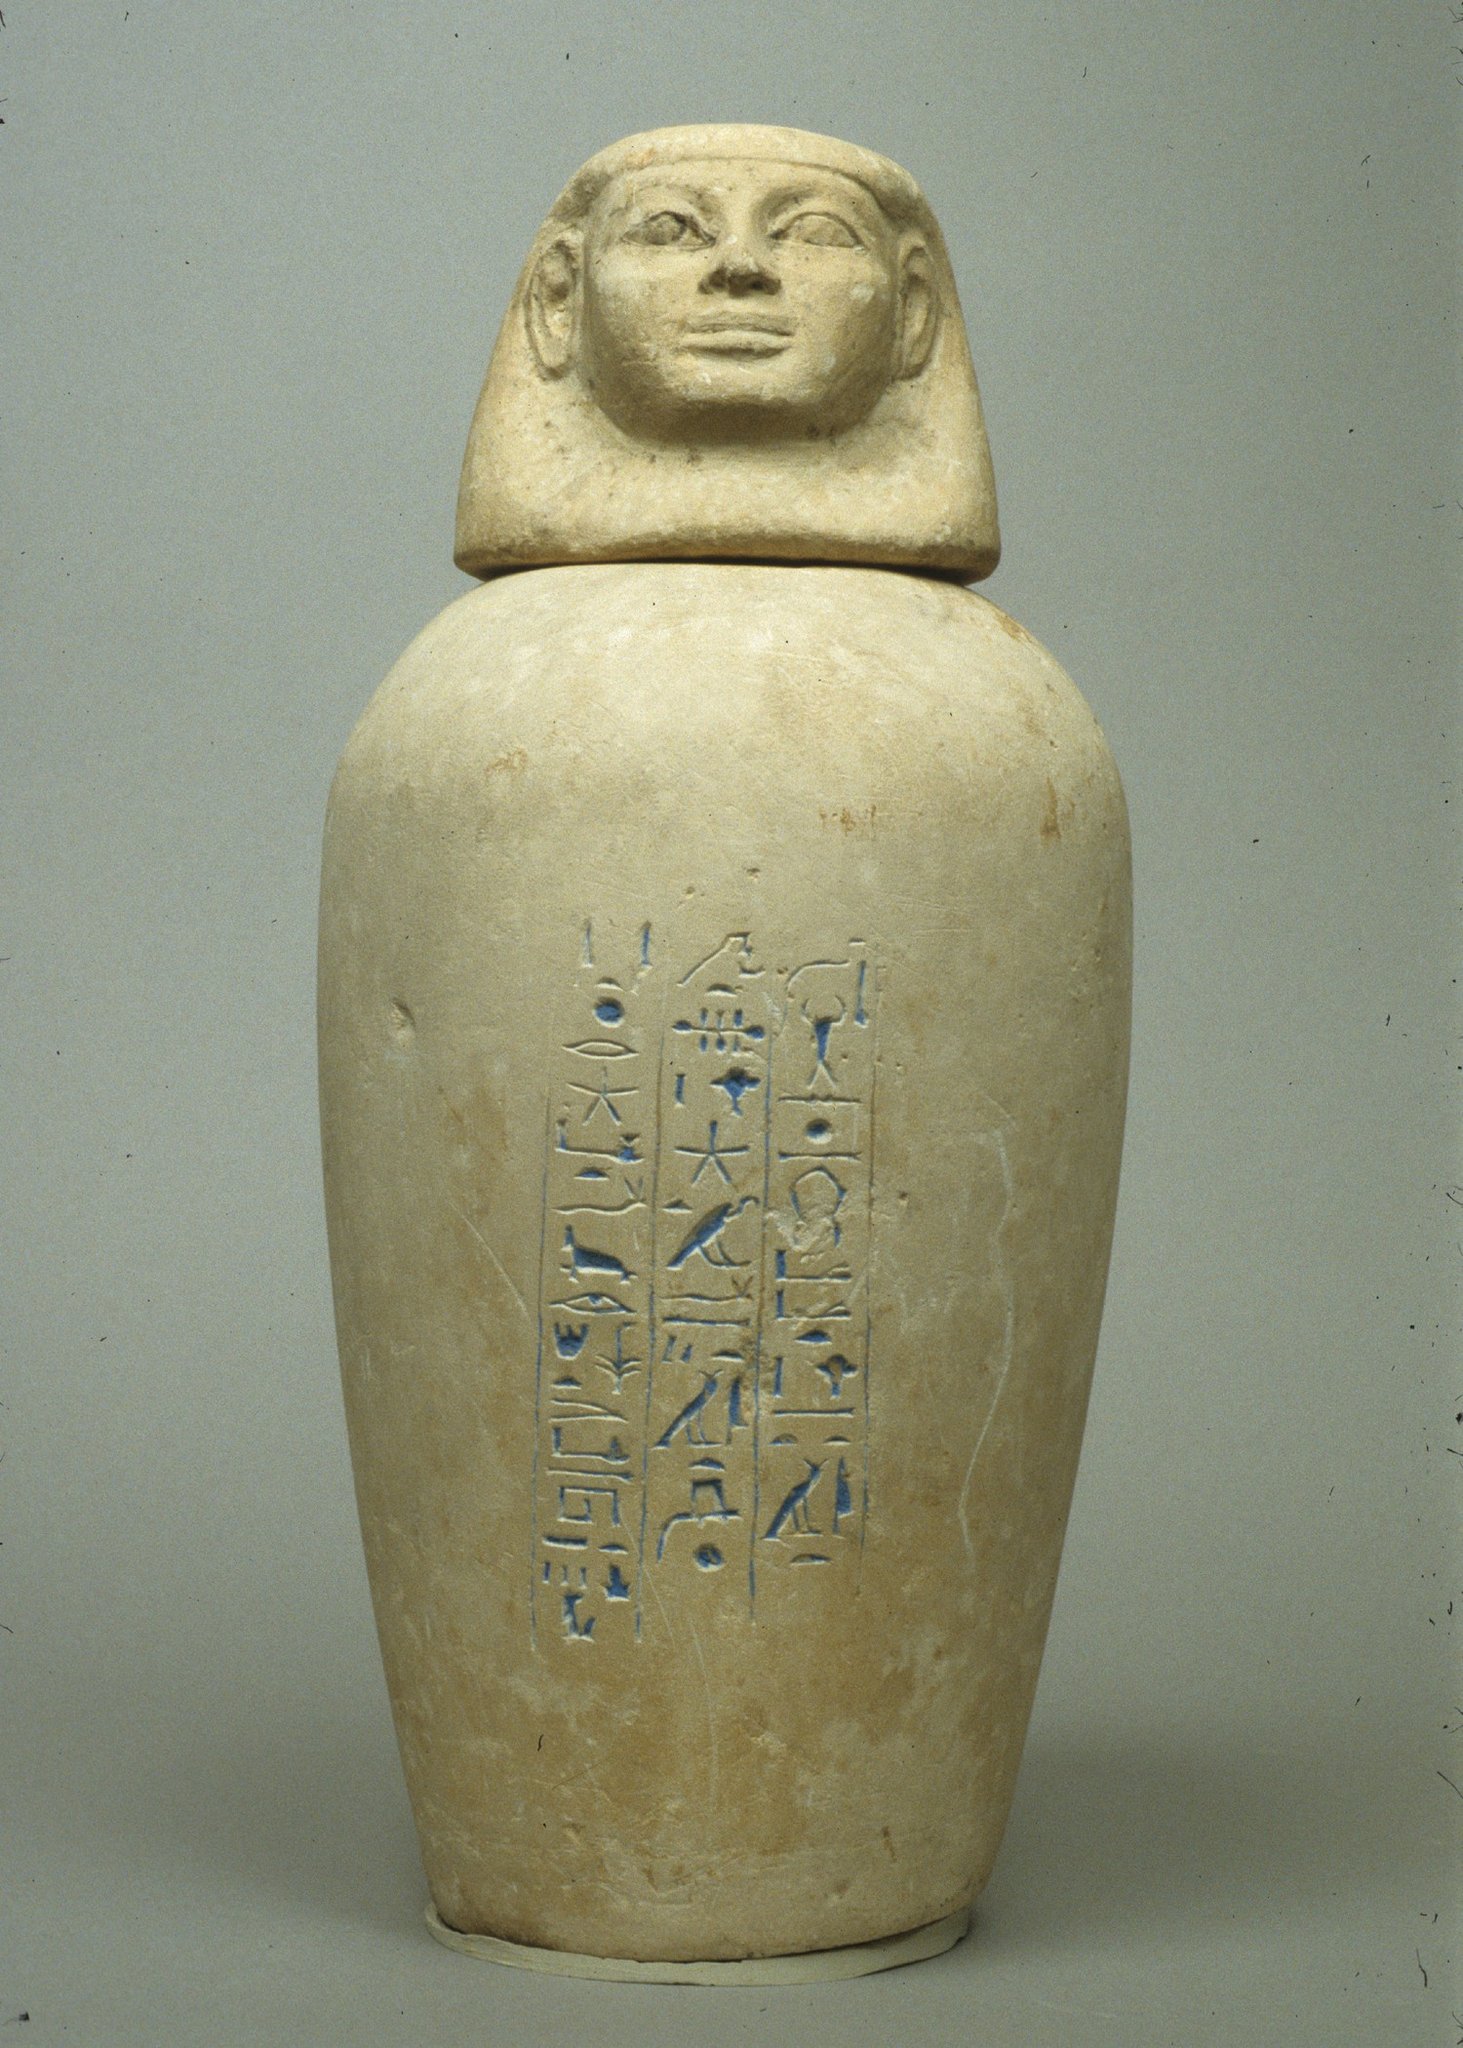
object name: canopic jar, manhata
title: Canopic Jar of Manhata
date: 1479-1425 BCE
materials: limestone, paste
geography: egypt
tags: hieroglyphs